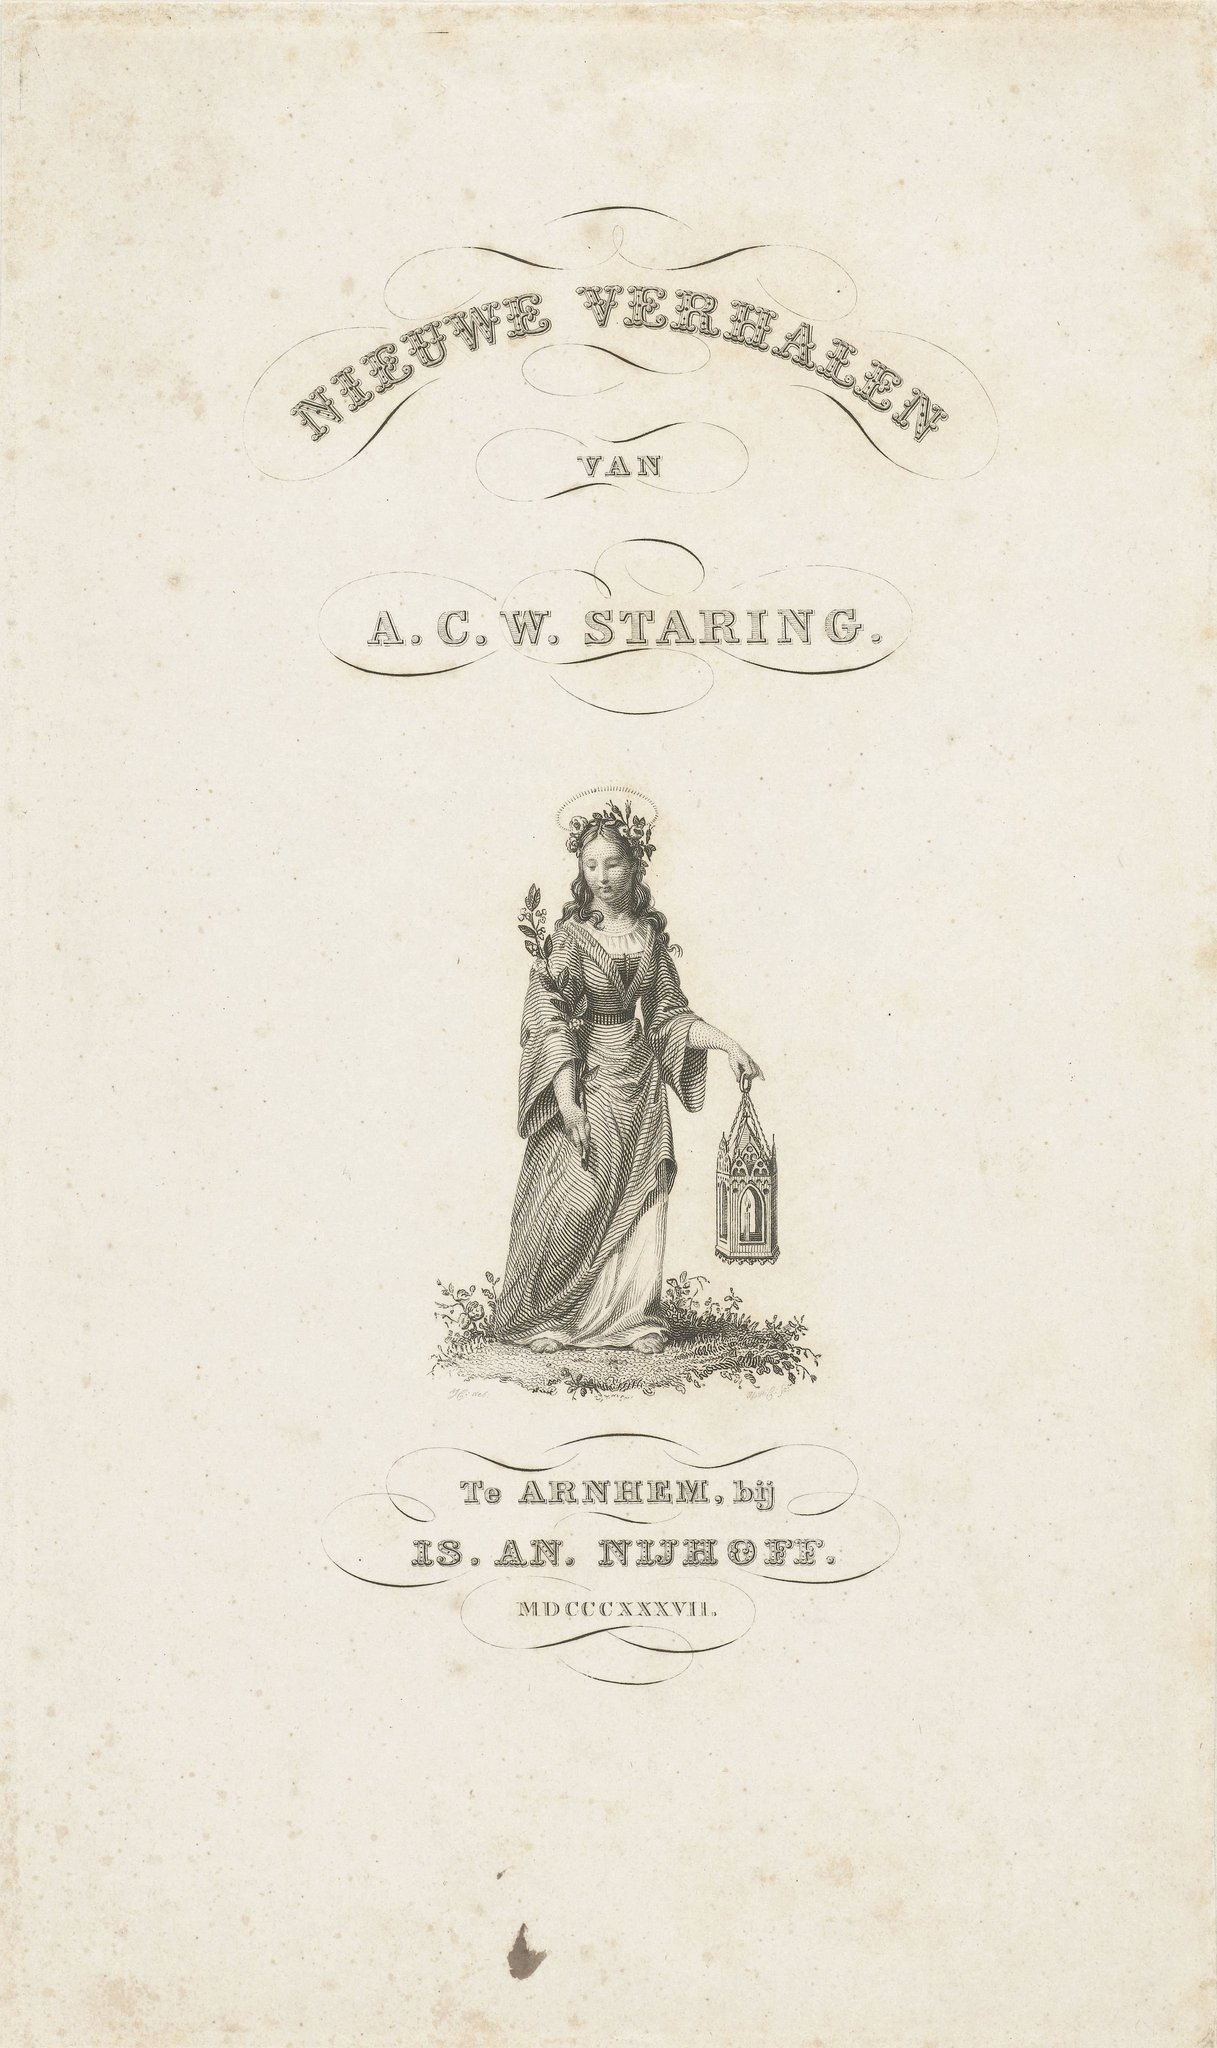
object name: print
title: Vrouwelijke heilige met lantaren en bloesemtak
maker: henricus wilhelmus couwenberg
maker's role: draughtsman, print maker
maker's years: 1814-1845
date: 1837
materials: paper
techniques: engraving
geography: amsterdam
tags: female saints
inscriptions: collector's mark: Lugt 2228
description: Titelpagina voor: A.C.W. Staring. Nieuwe Verhalen. Arnhem: I.A. Nijhoff, 1837.